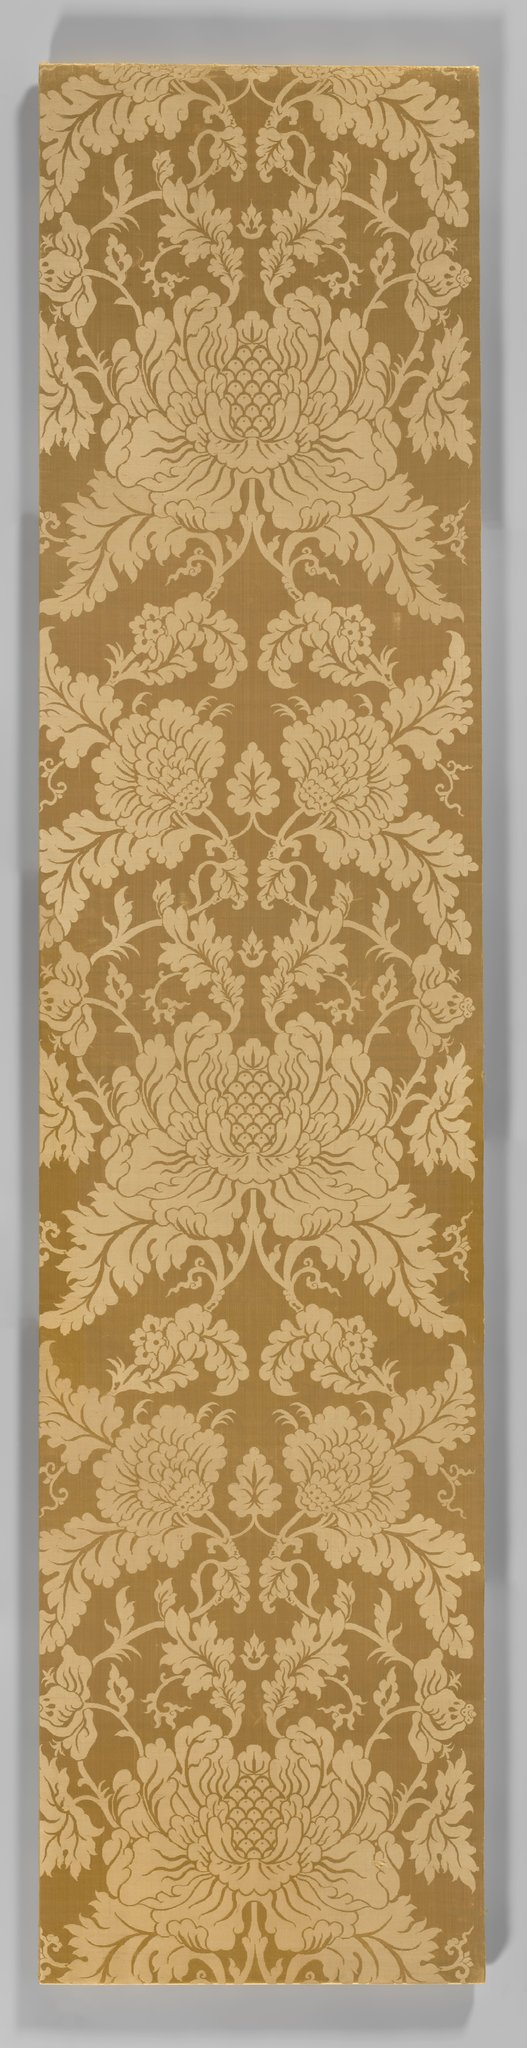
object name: silk textile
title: Wandbespanning van geel zijden damasten met symmetrisch patroon van twee opgaande golvende ranken met onder andere pioenvormige bloemen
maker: Anonymous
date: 1700-1725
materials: silk, wood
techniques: damask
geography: france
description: Geel zijden damasten wandbespanning. Symmetrisch patroon van twee opgaande golvende ranken waaraan grote pioenvormige bloemen met geschubtd hart; kleinere bloemen zijn paarsgewijs geplaatst, evenals bloemknoppen, gevederde bladeren en arabeskrankjes, die eindigen in wolkenbanden. Patroon van keperstreep, fond van satijnbinding. Afkomstig uit het pand Voorstraat 140 te Dordrecht. Eén baan heeft aan de onderkant wat waterschade.